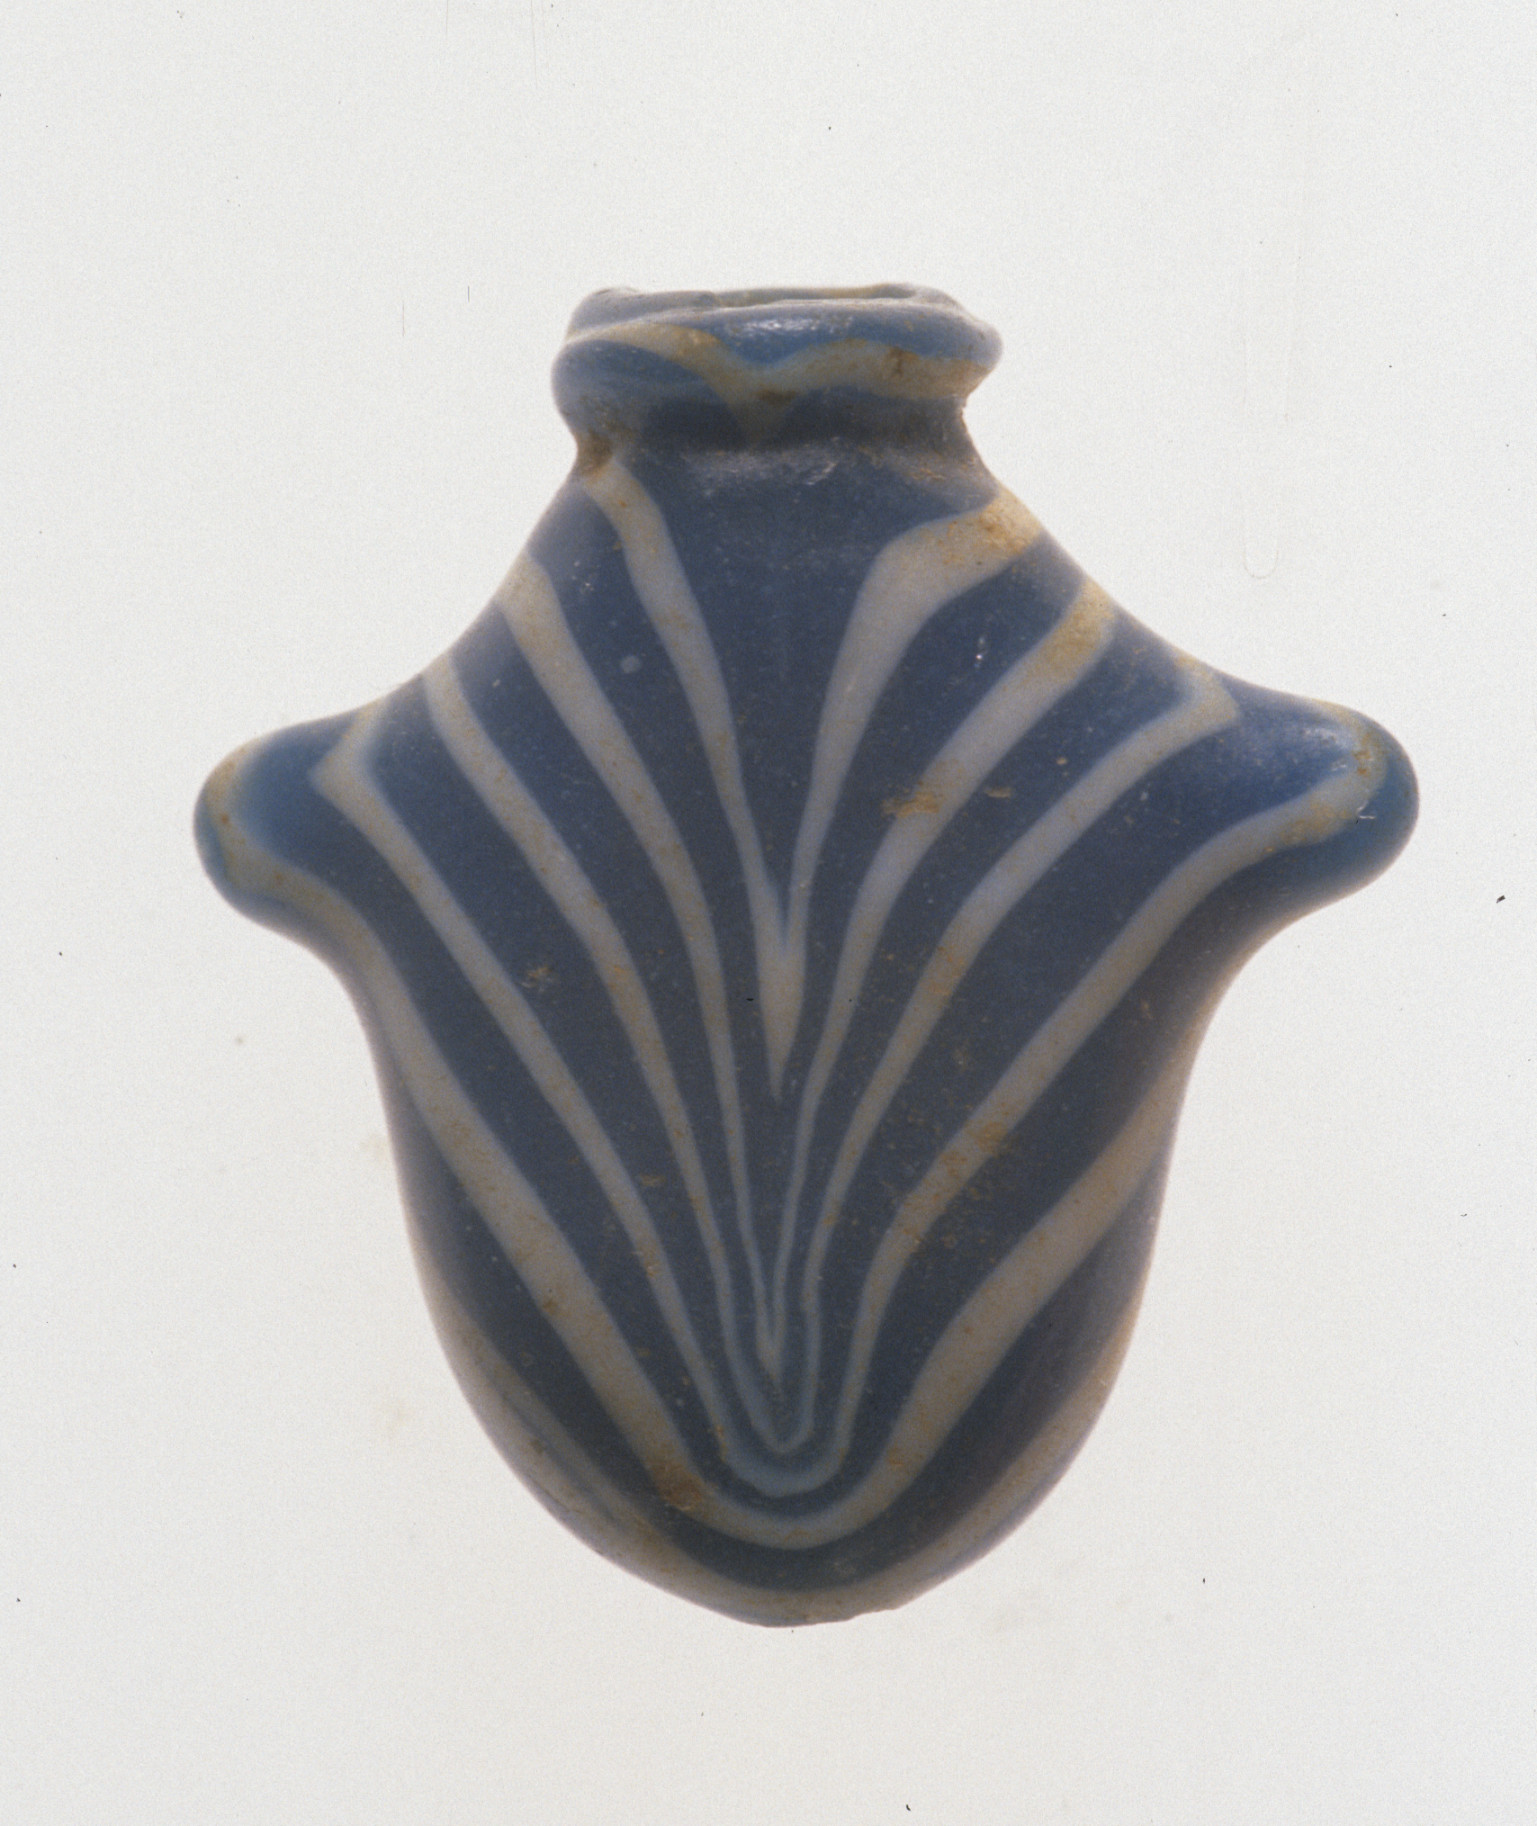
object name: amulet, heart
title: Heart amulet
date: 1550-1186 BCE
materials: glass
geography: egypt